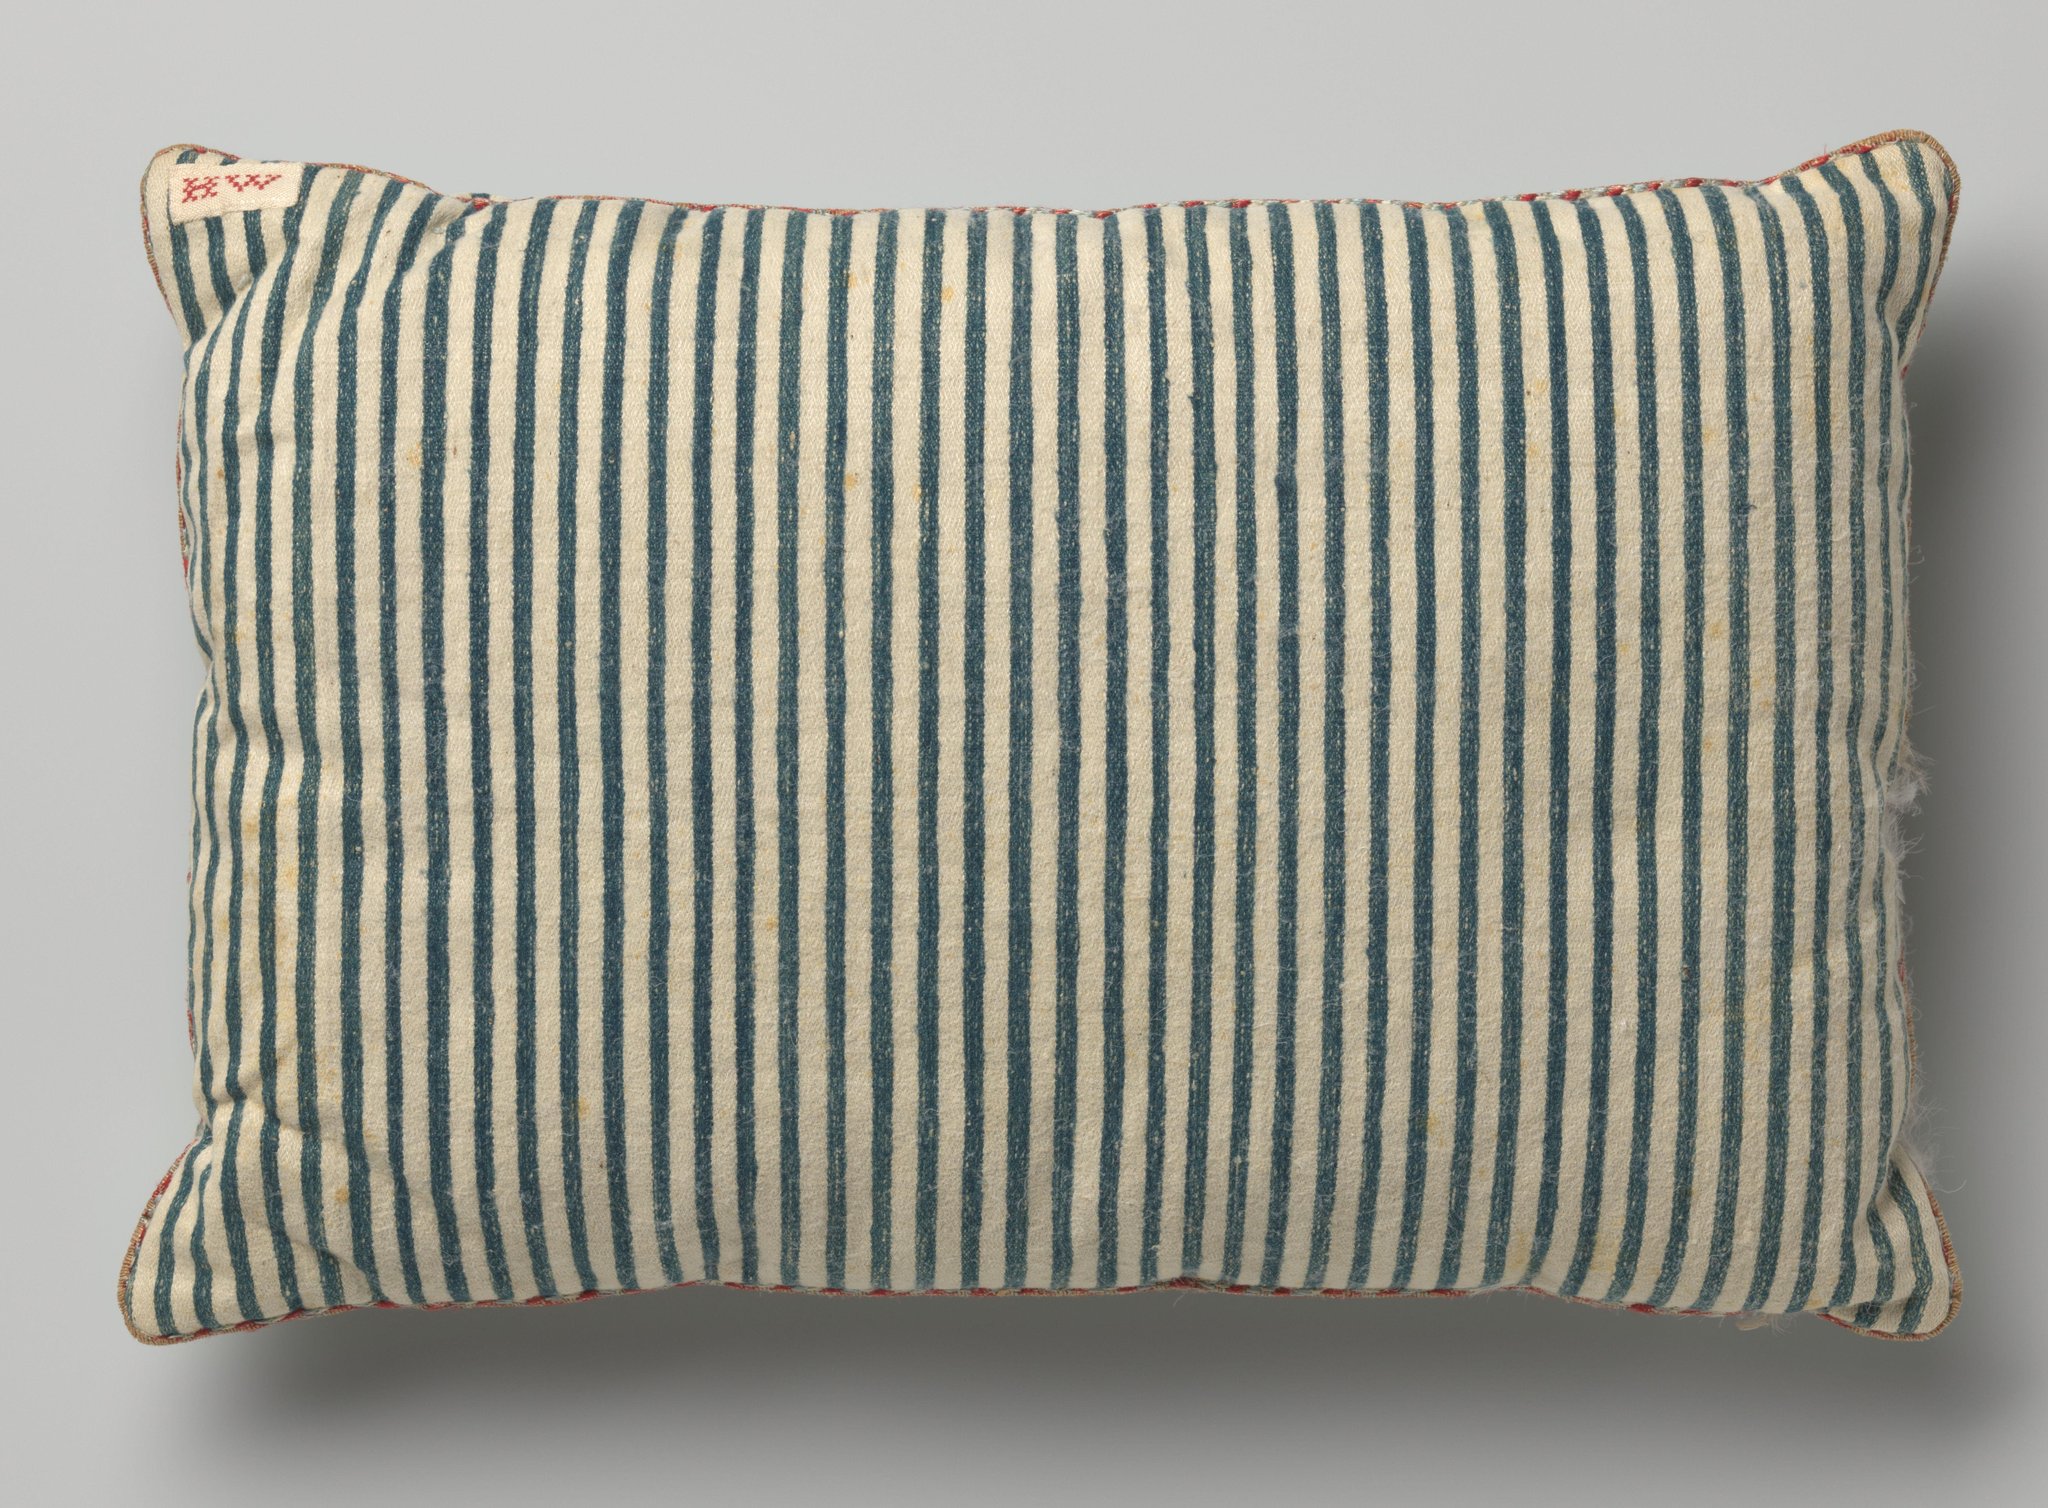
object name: lendenkussen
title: Kussen, overtrokken met tijk en rondom een koord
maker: Anonymous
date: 1700-1850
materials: textile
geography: northern netherlands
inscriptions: initials: ‘HW’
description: Lendenkussen overtrokken met tijk en rondom een kleurig koord. In een hoek initialen HW.